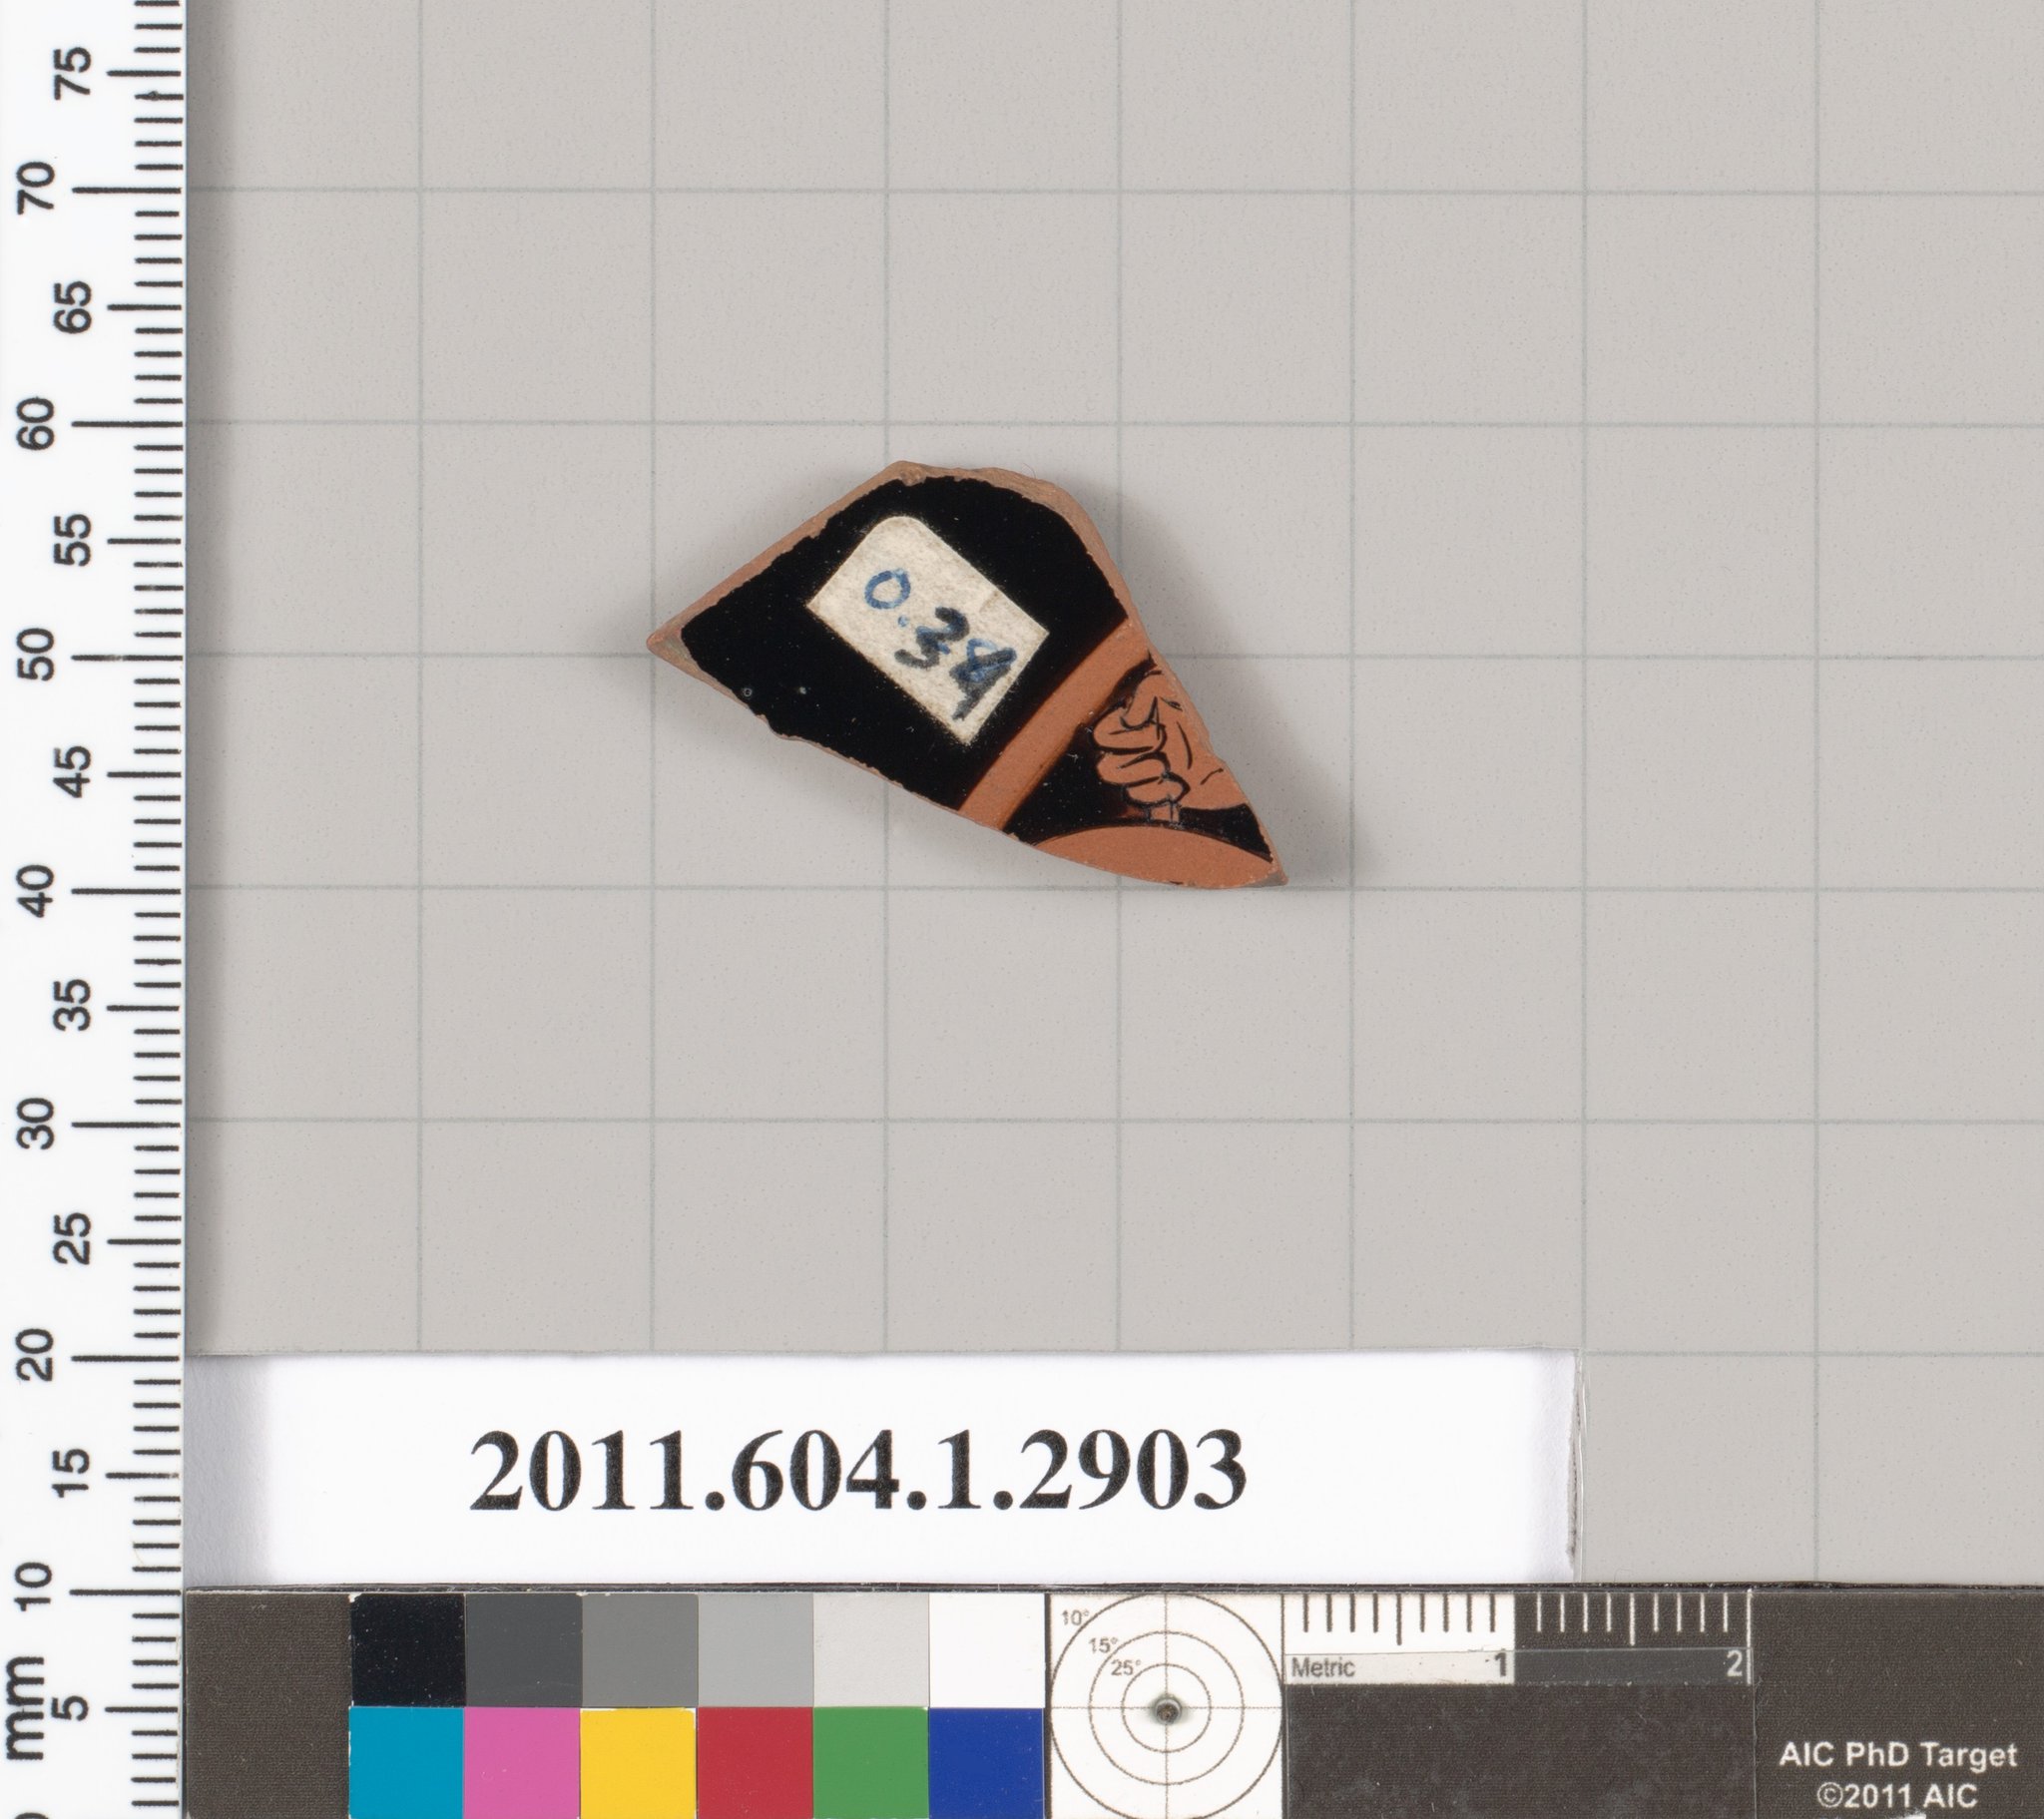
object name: kylix fragment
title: Terracotta fragment of a kylix (drinking cup)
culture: greek, attic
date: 500-490 BCE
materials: terracotta